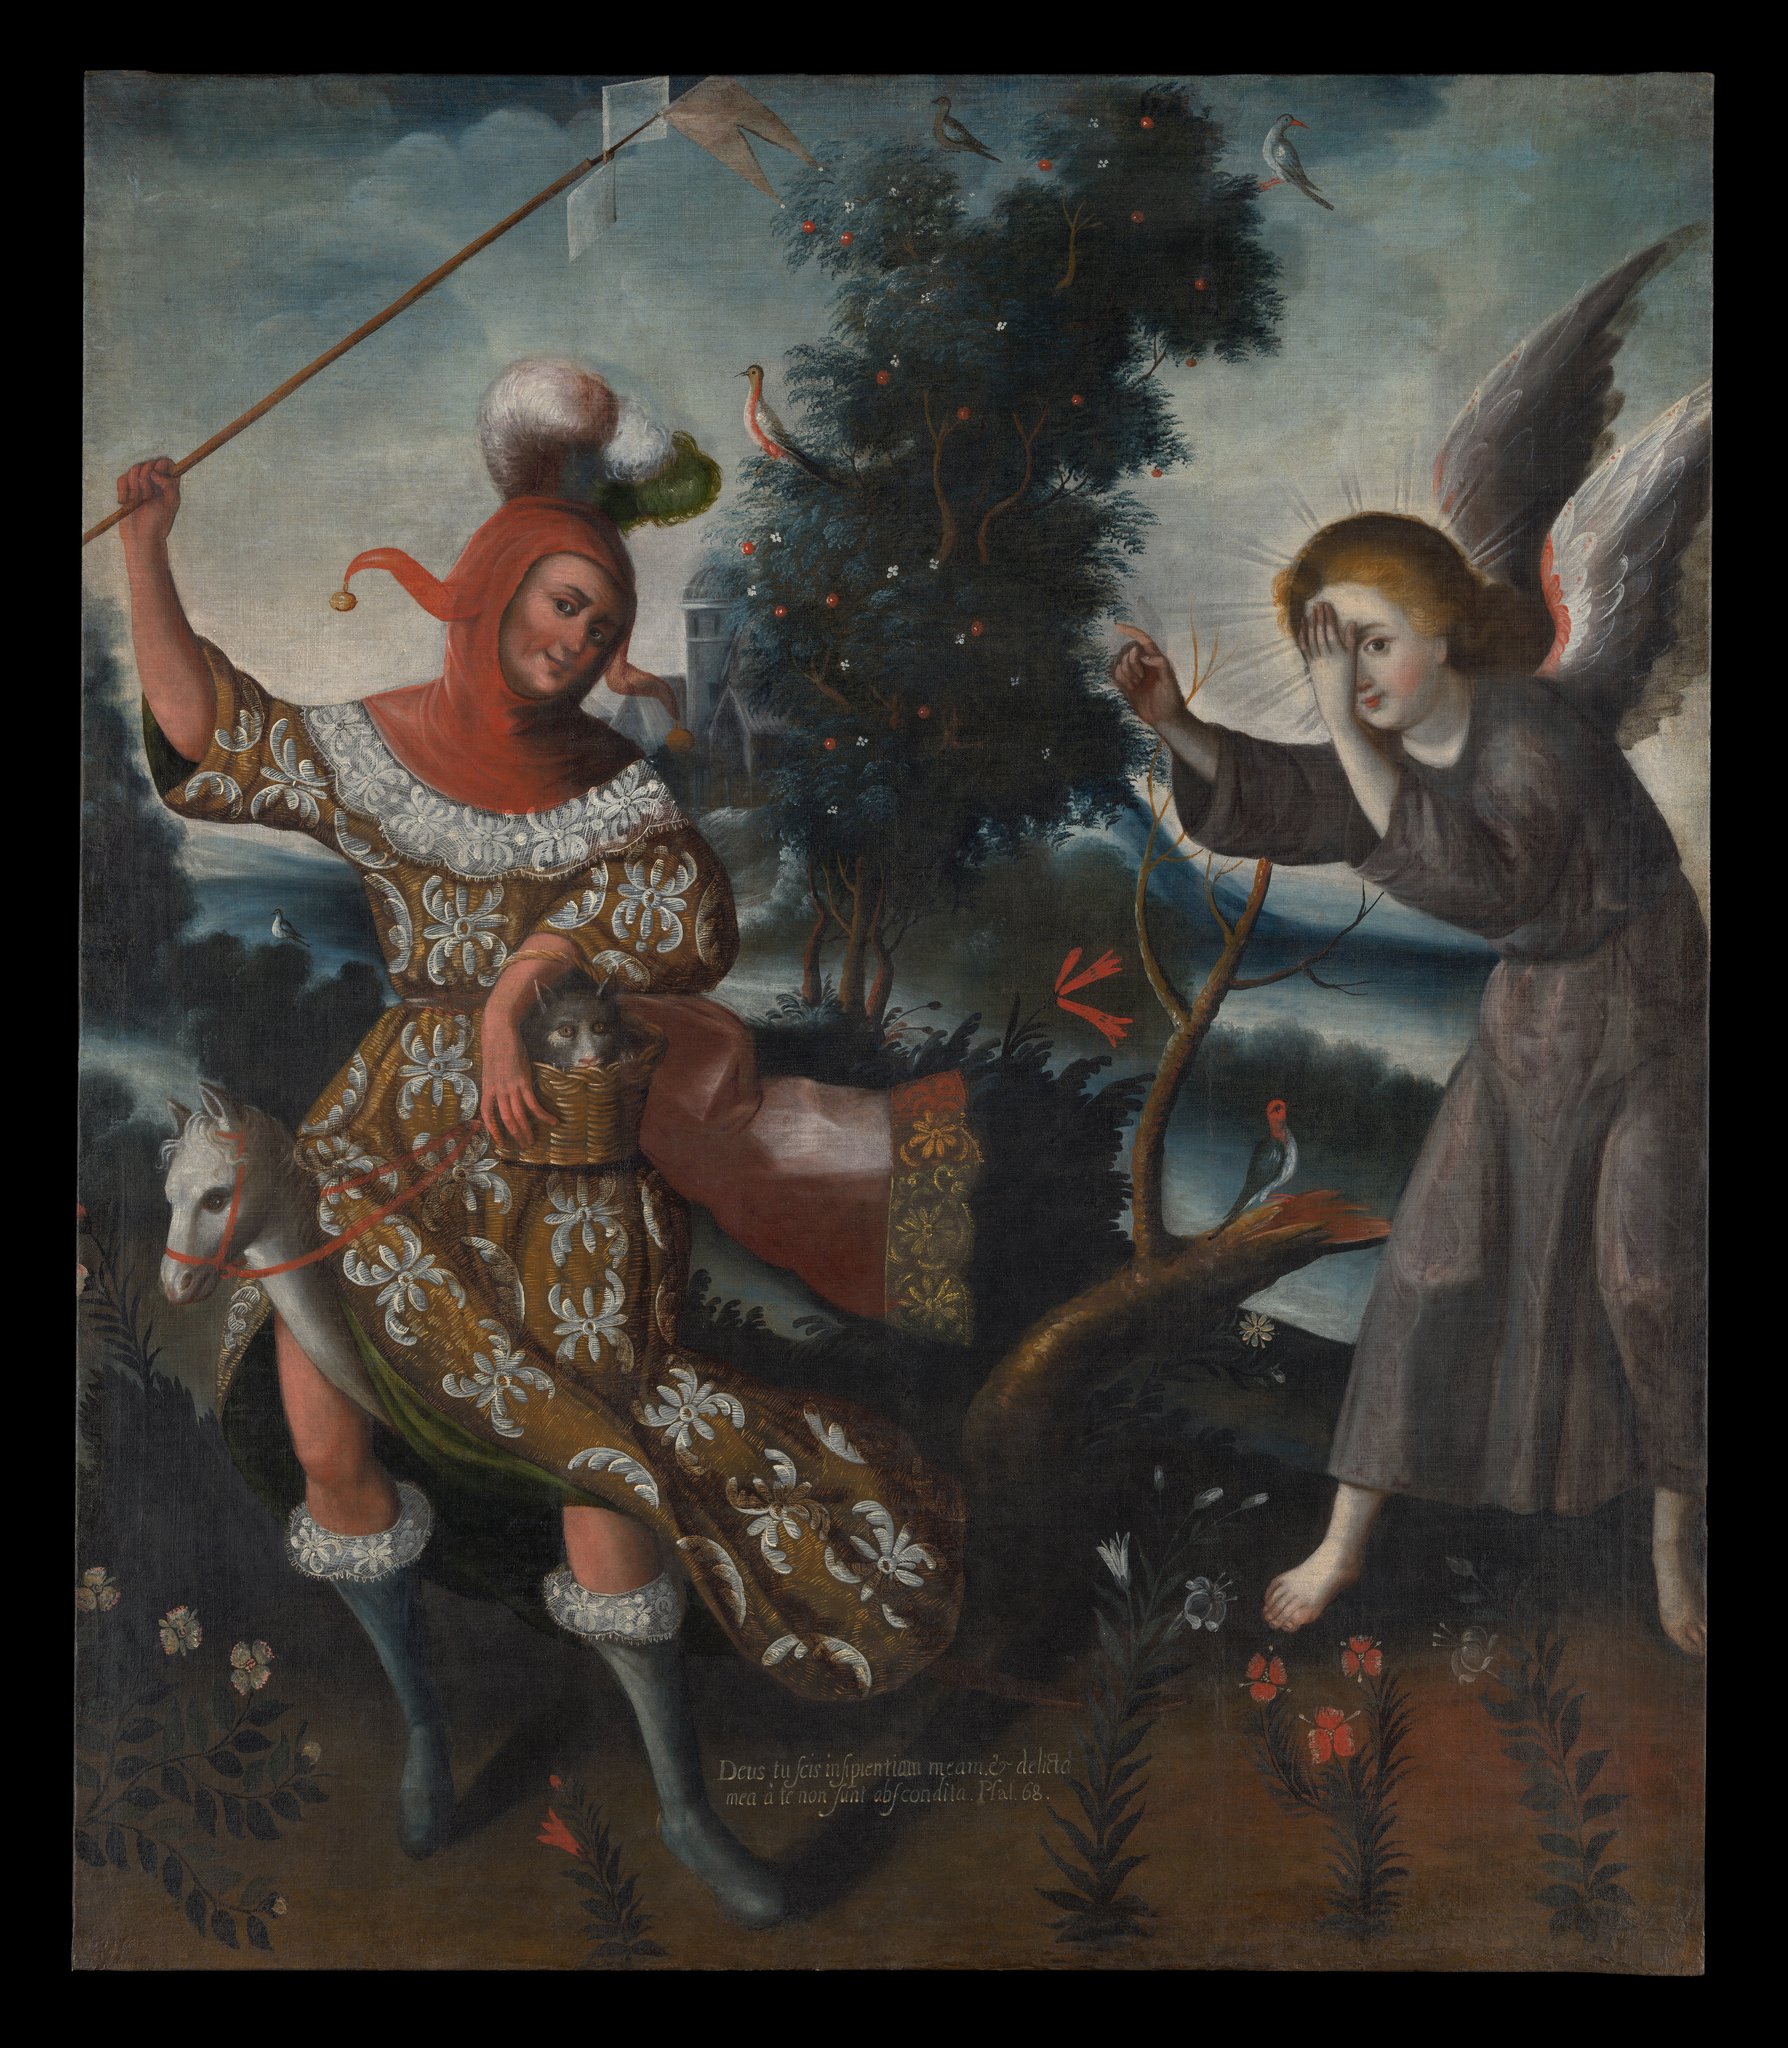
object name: painting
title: Emblem of Folly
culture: peruvian, cuzco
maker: Anonymous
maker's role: artist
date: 1701-1800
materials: canvas, oil